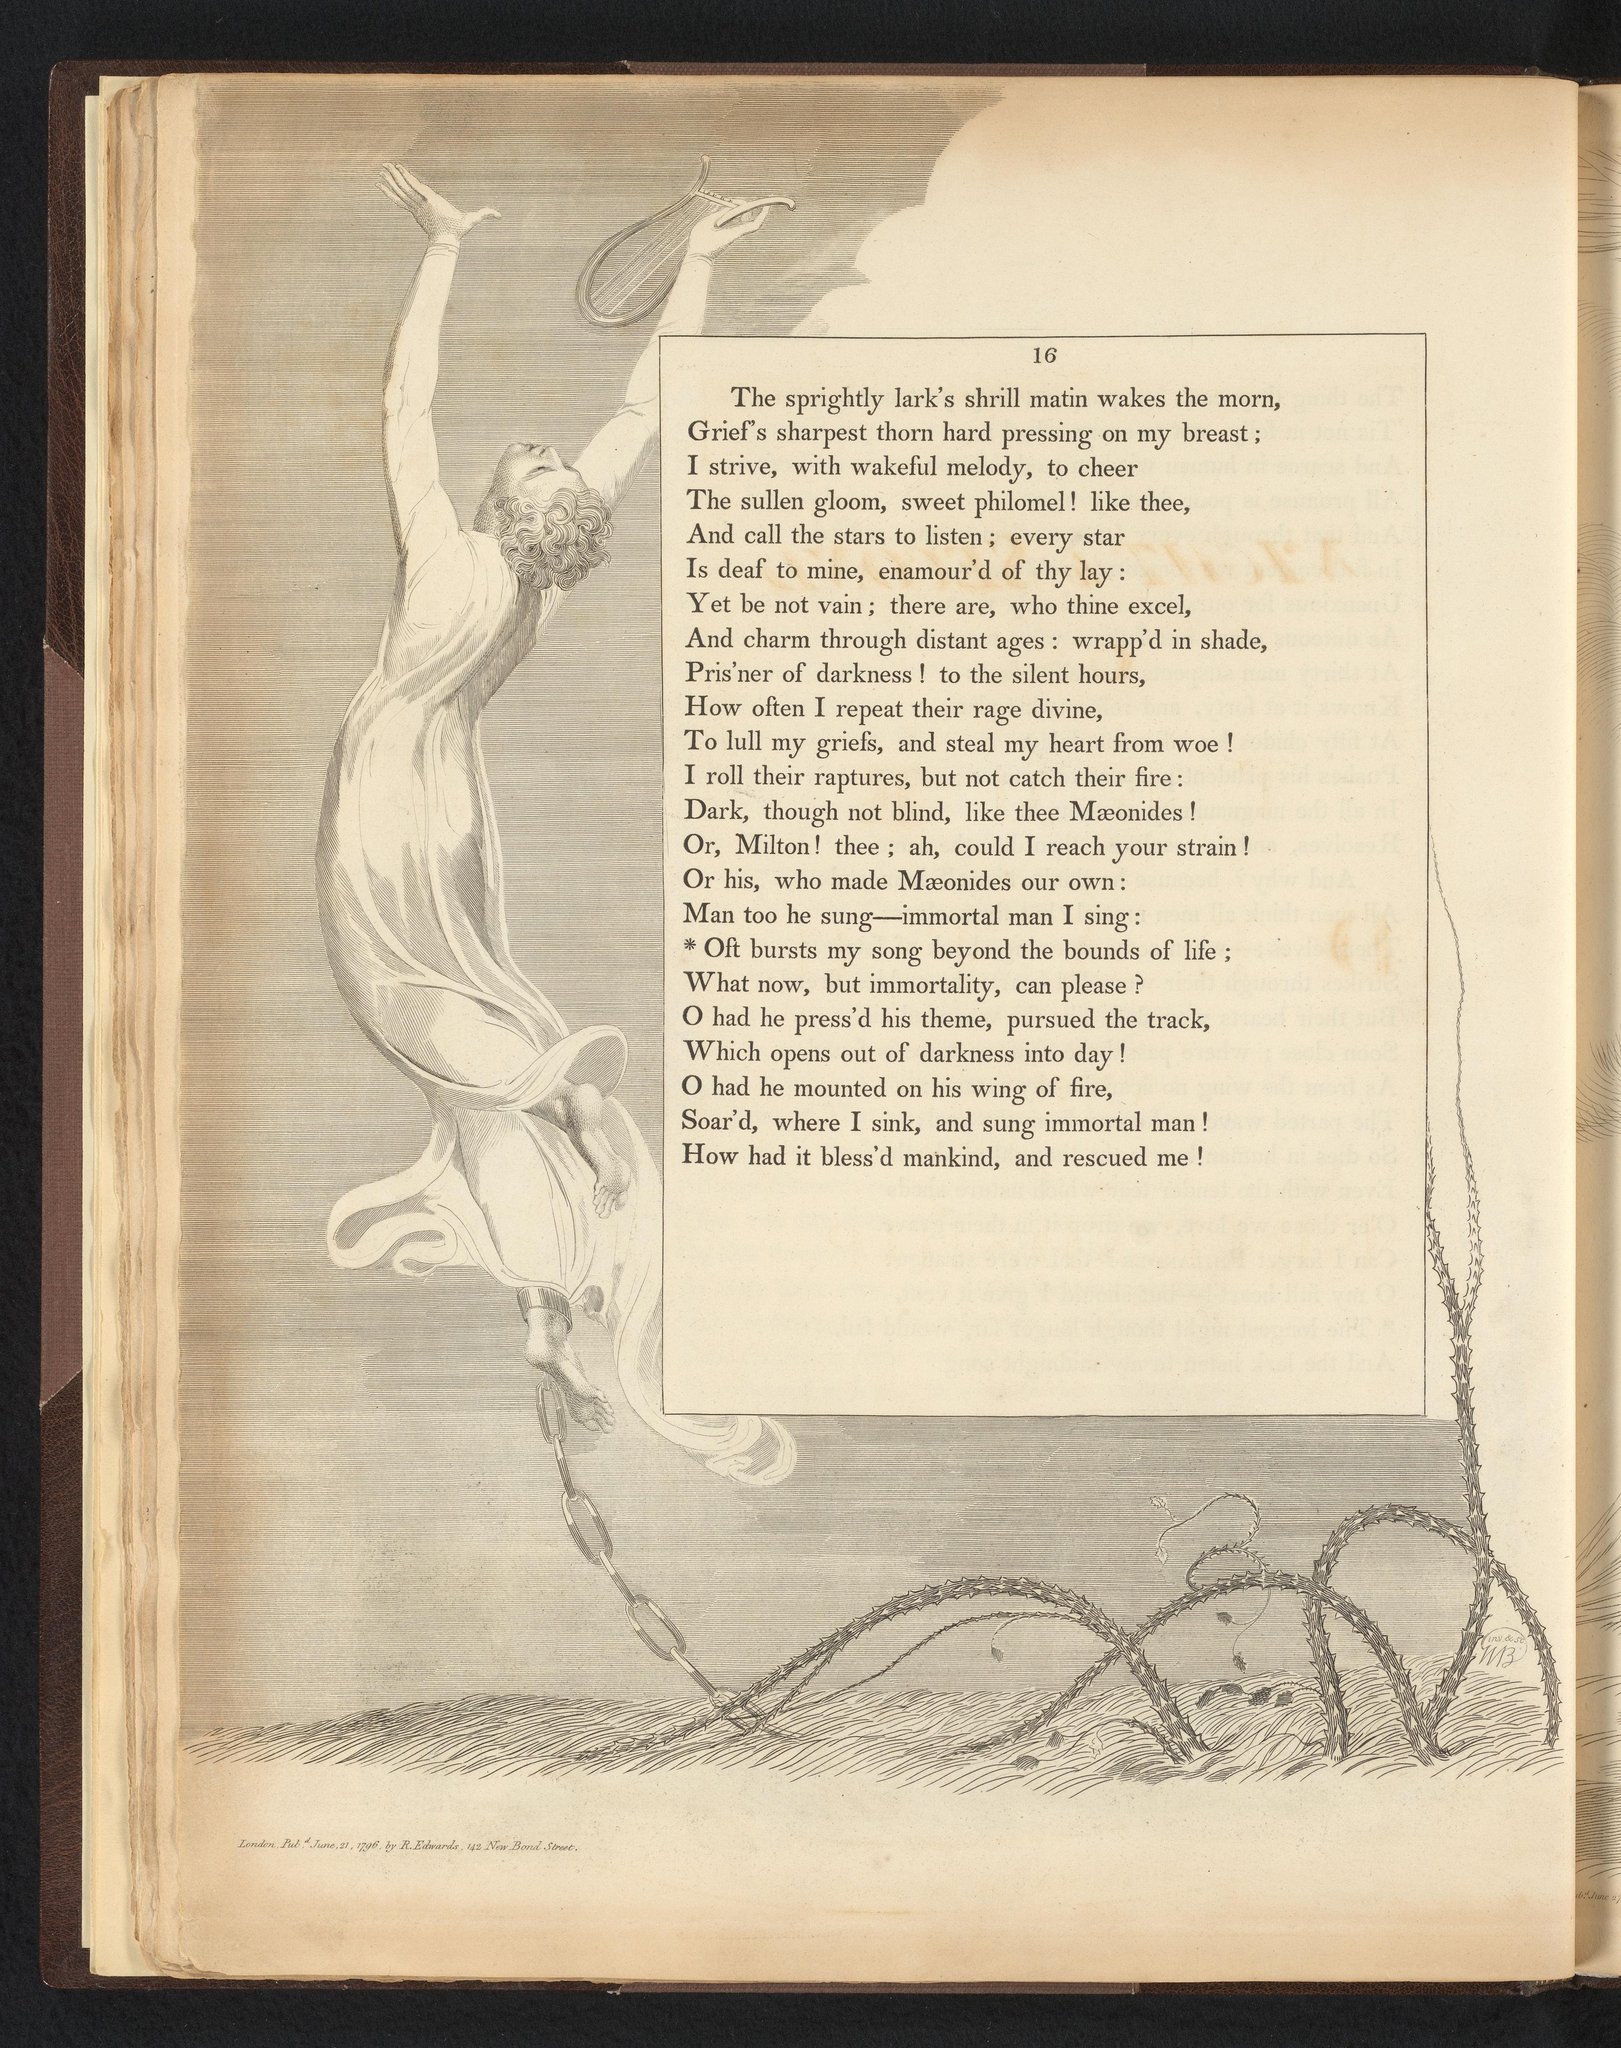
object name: page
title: Geketende man stijgt op met lier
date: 1796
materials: paper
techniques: engraving, letterpress printing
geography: london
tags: lyre, cithara, psaltery, adult man, imprisonment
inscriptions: : ‘The sprightly lark's shrill matin wakes the morn, (...)’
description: Prent maakt deel uit van een boek, bladzijde 16. Tekst in het Engels op recto en verso.